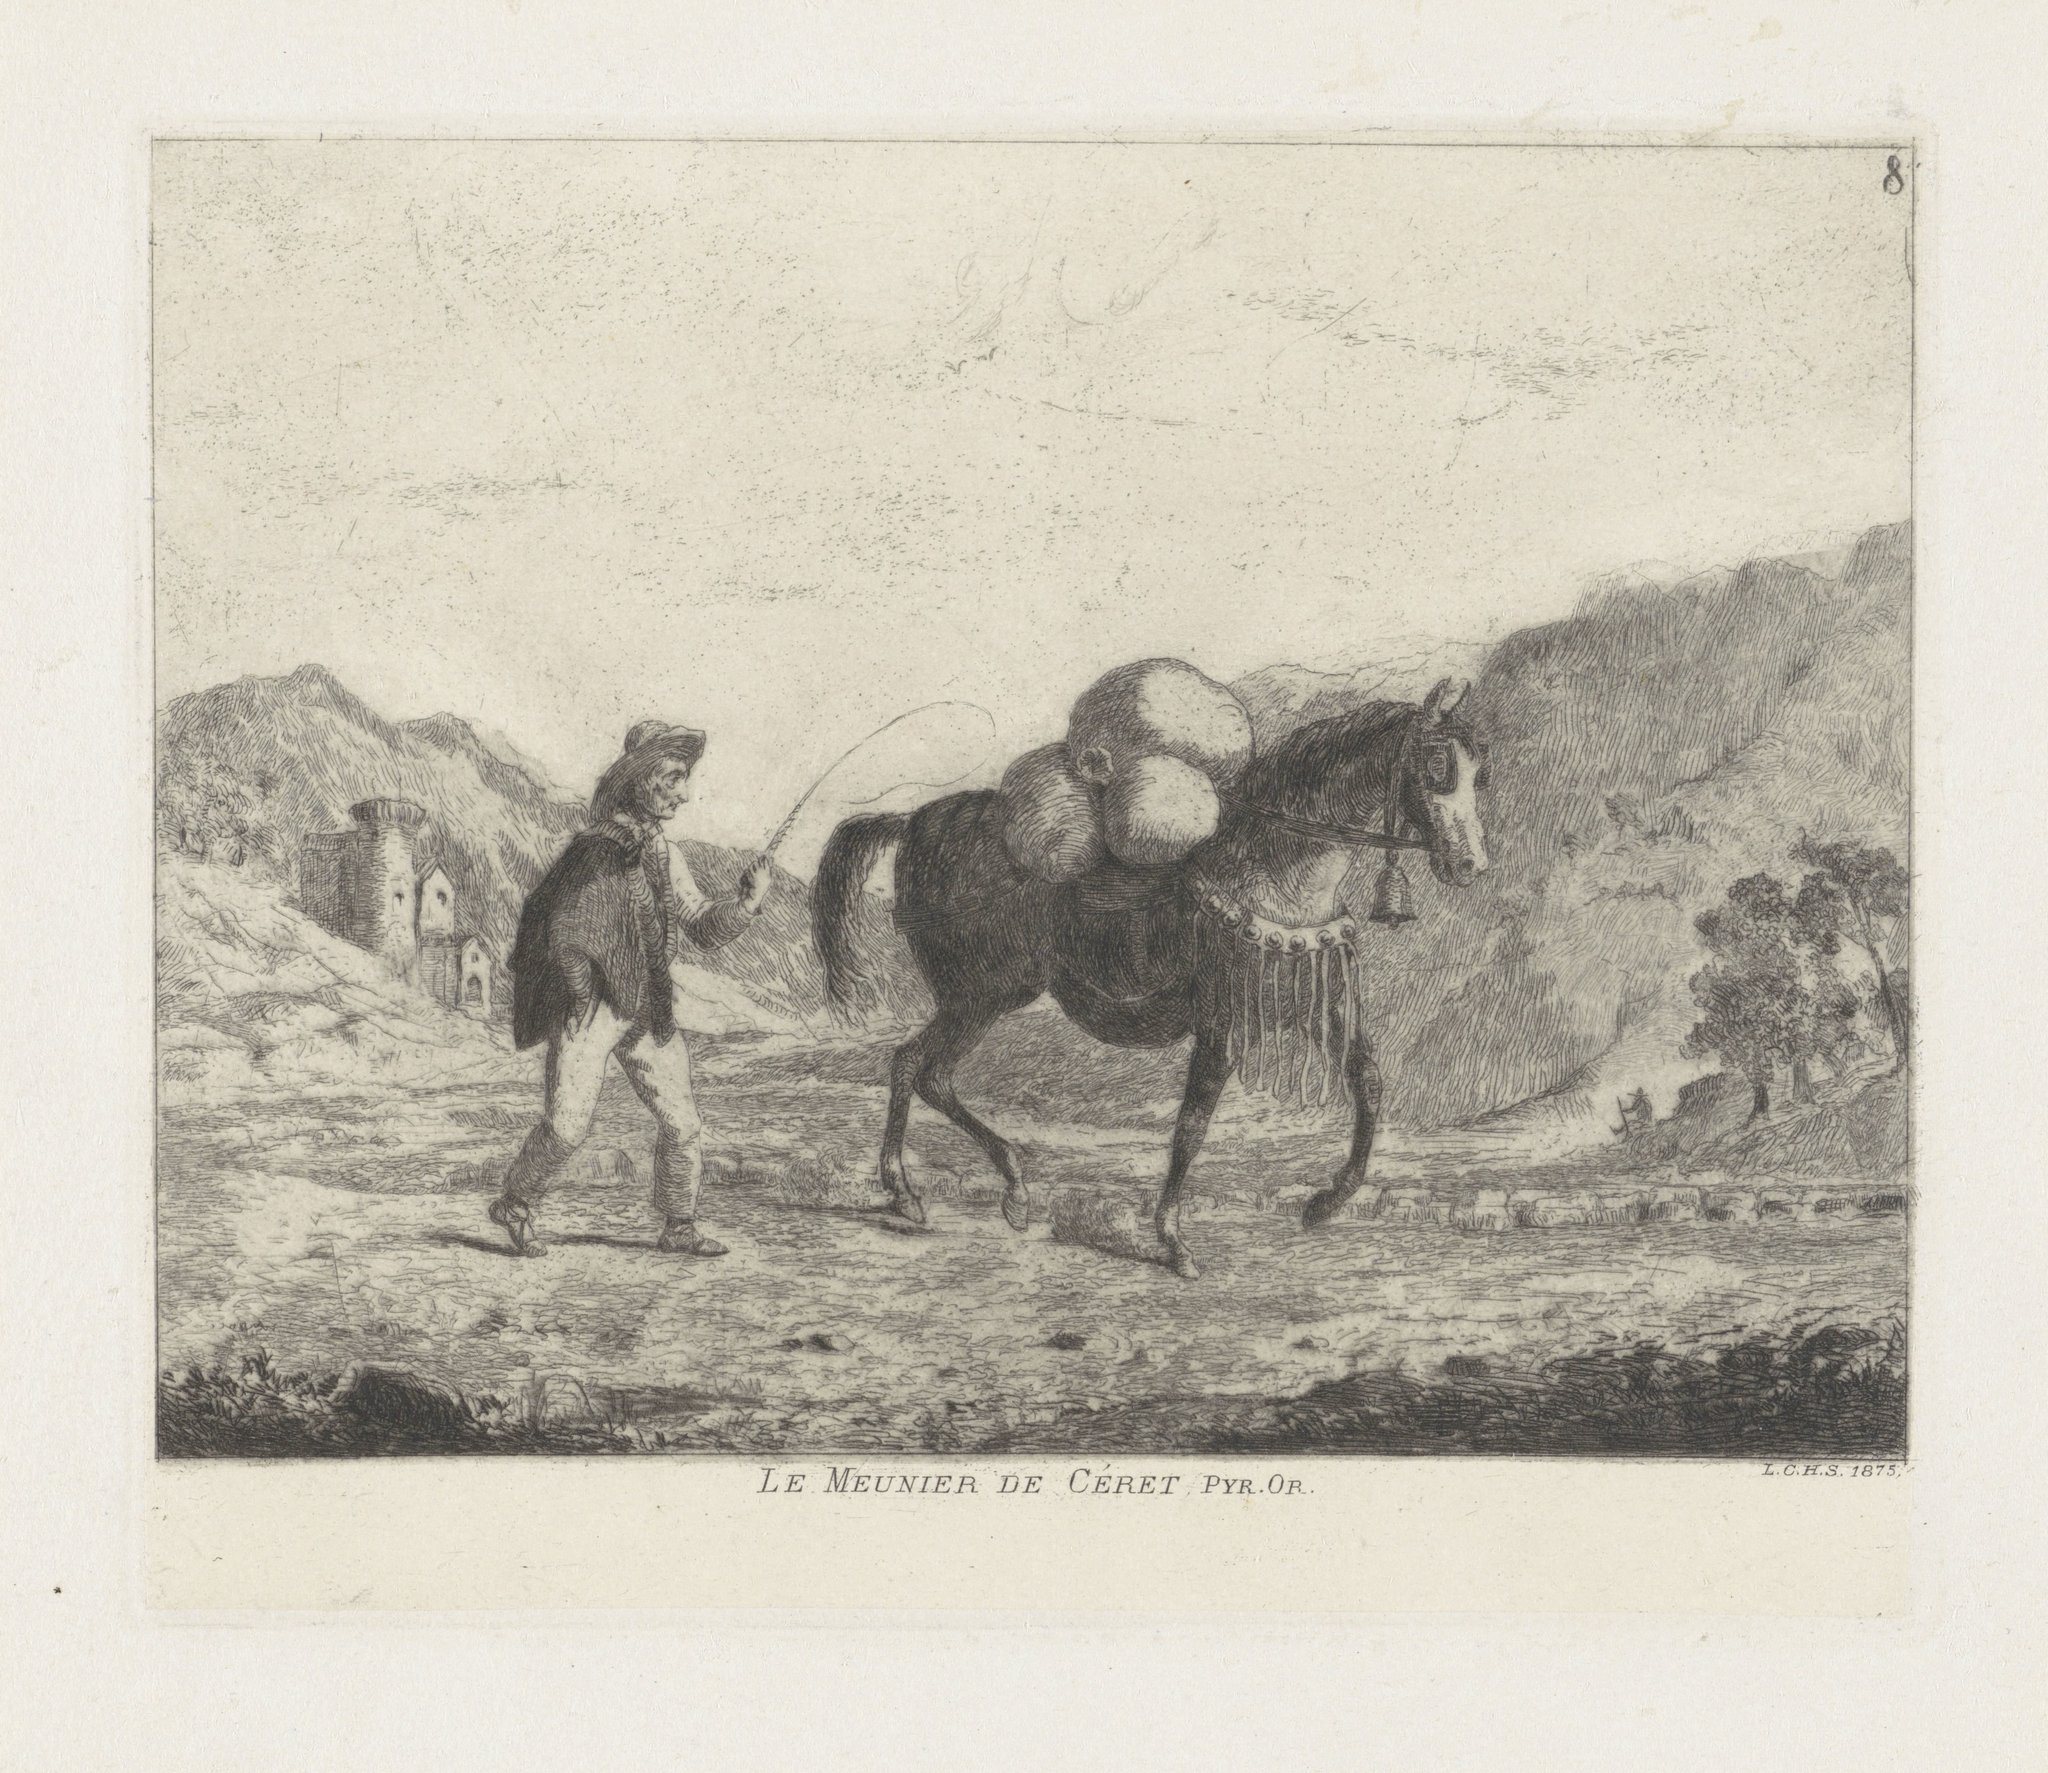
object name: print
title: Le Meunier de Céret (Pyr. or.)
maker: louis charles hora siccama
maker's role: draughtsman, print maker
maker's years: 1807-1880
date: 1875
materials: paper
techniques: etching, intaglio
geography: utrecht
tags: animal mounts; pack-animals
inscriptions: collector's mark: Lugt 2228